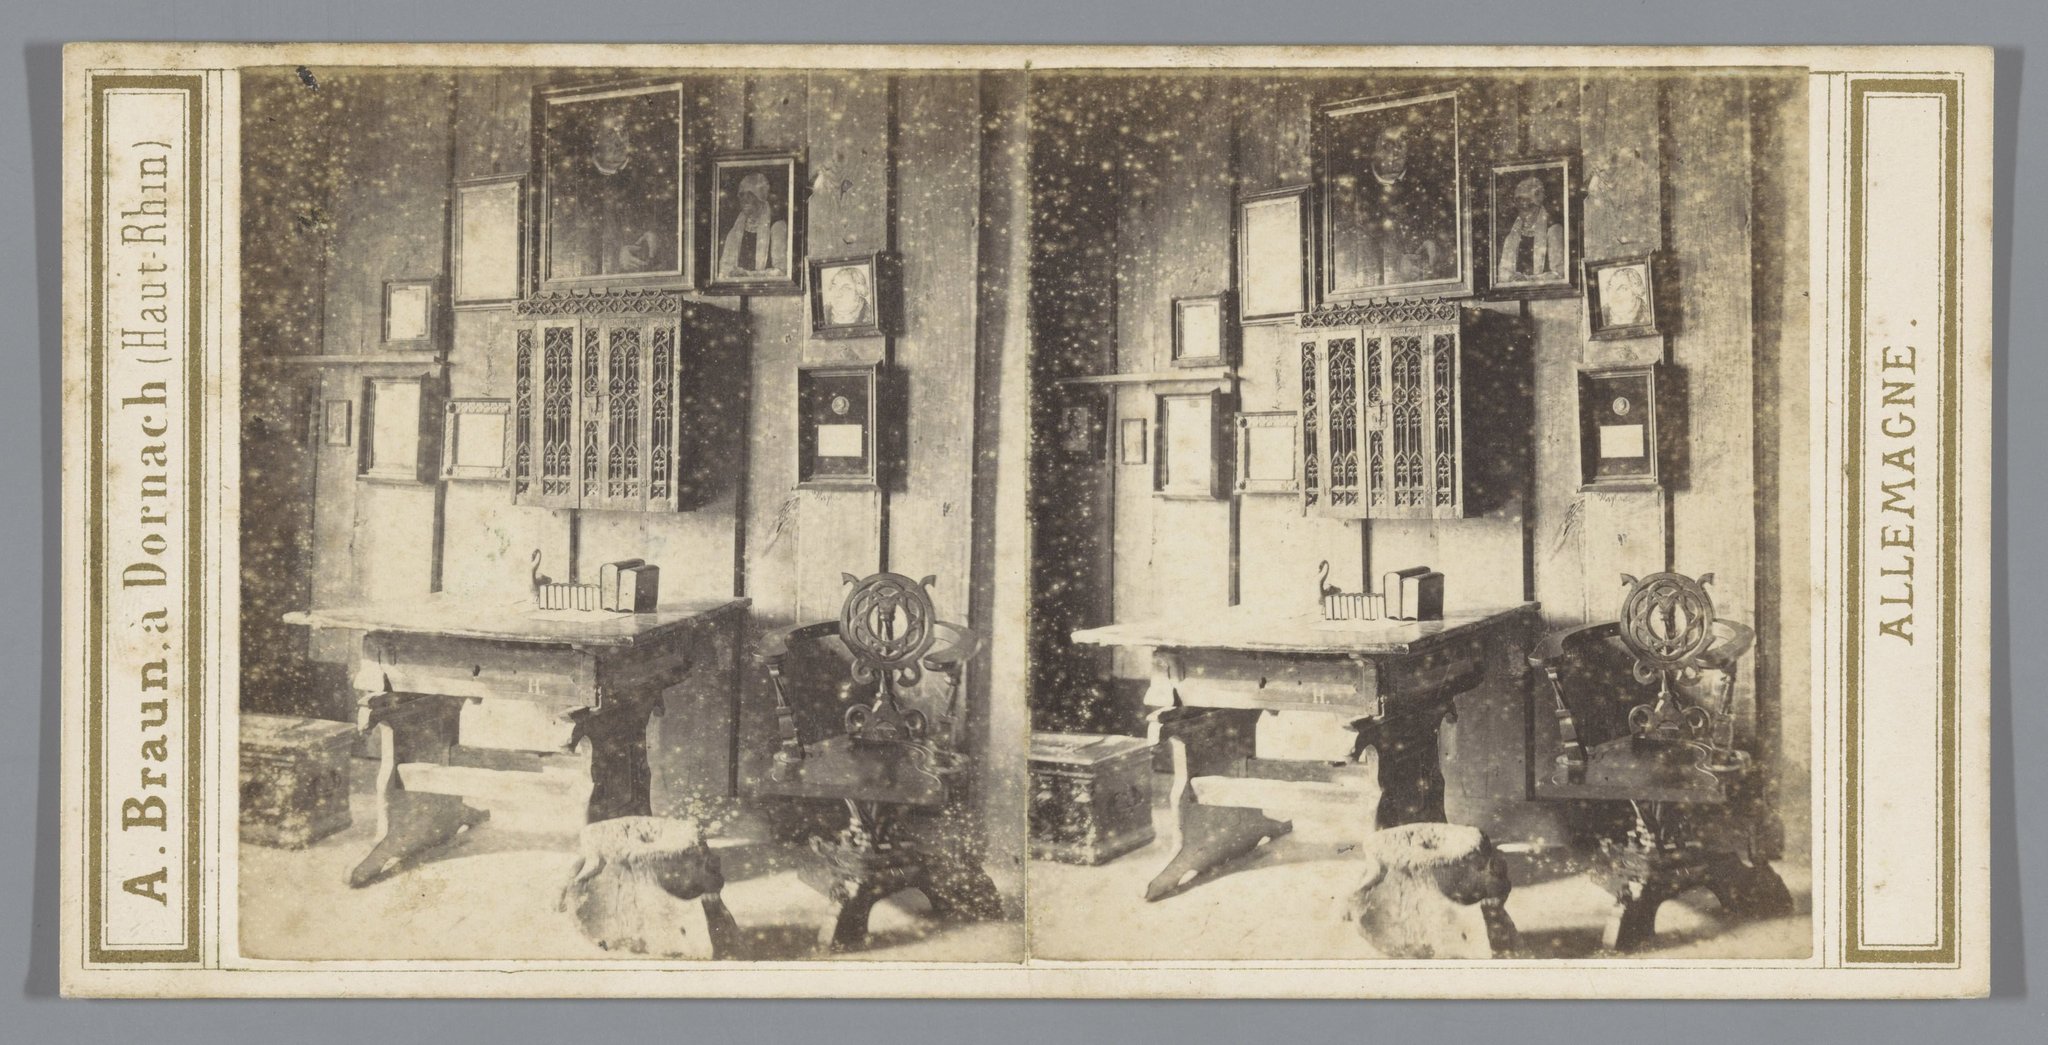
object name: stereograph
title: Allemagne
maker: Anonymous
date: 1860-1866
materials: cardboard, paper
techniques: albumen print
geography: dornach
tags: priest, martin luther, housing, furniture and household effects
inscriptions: number: ‘No 3496.’